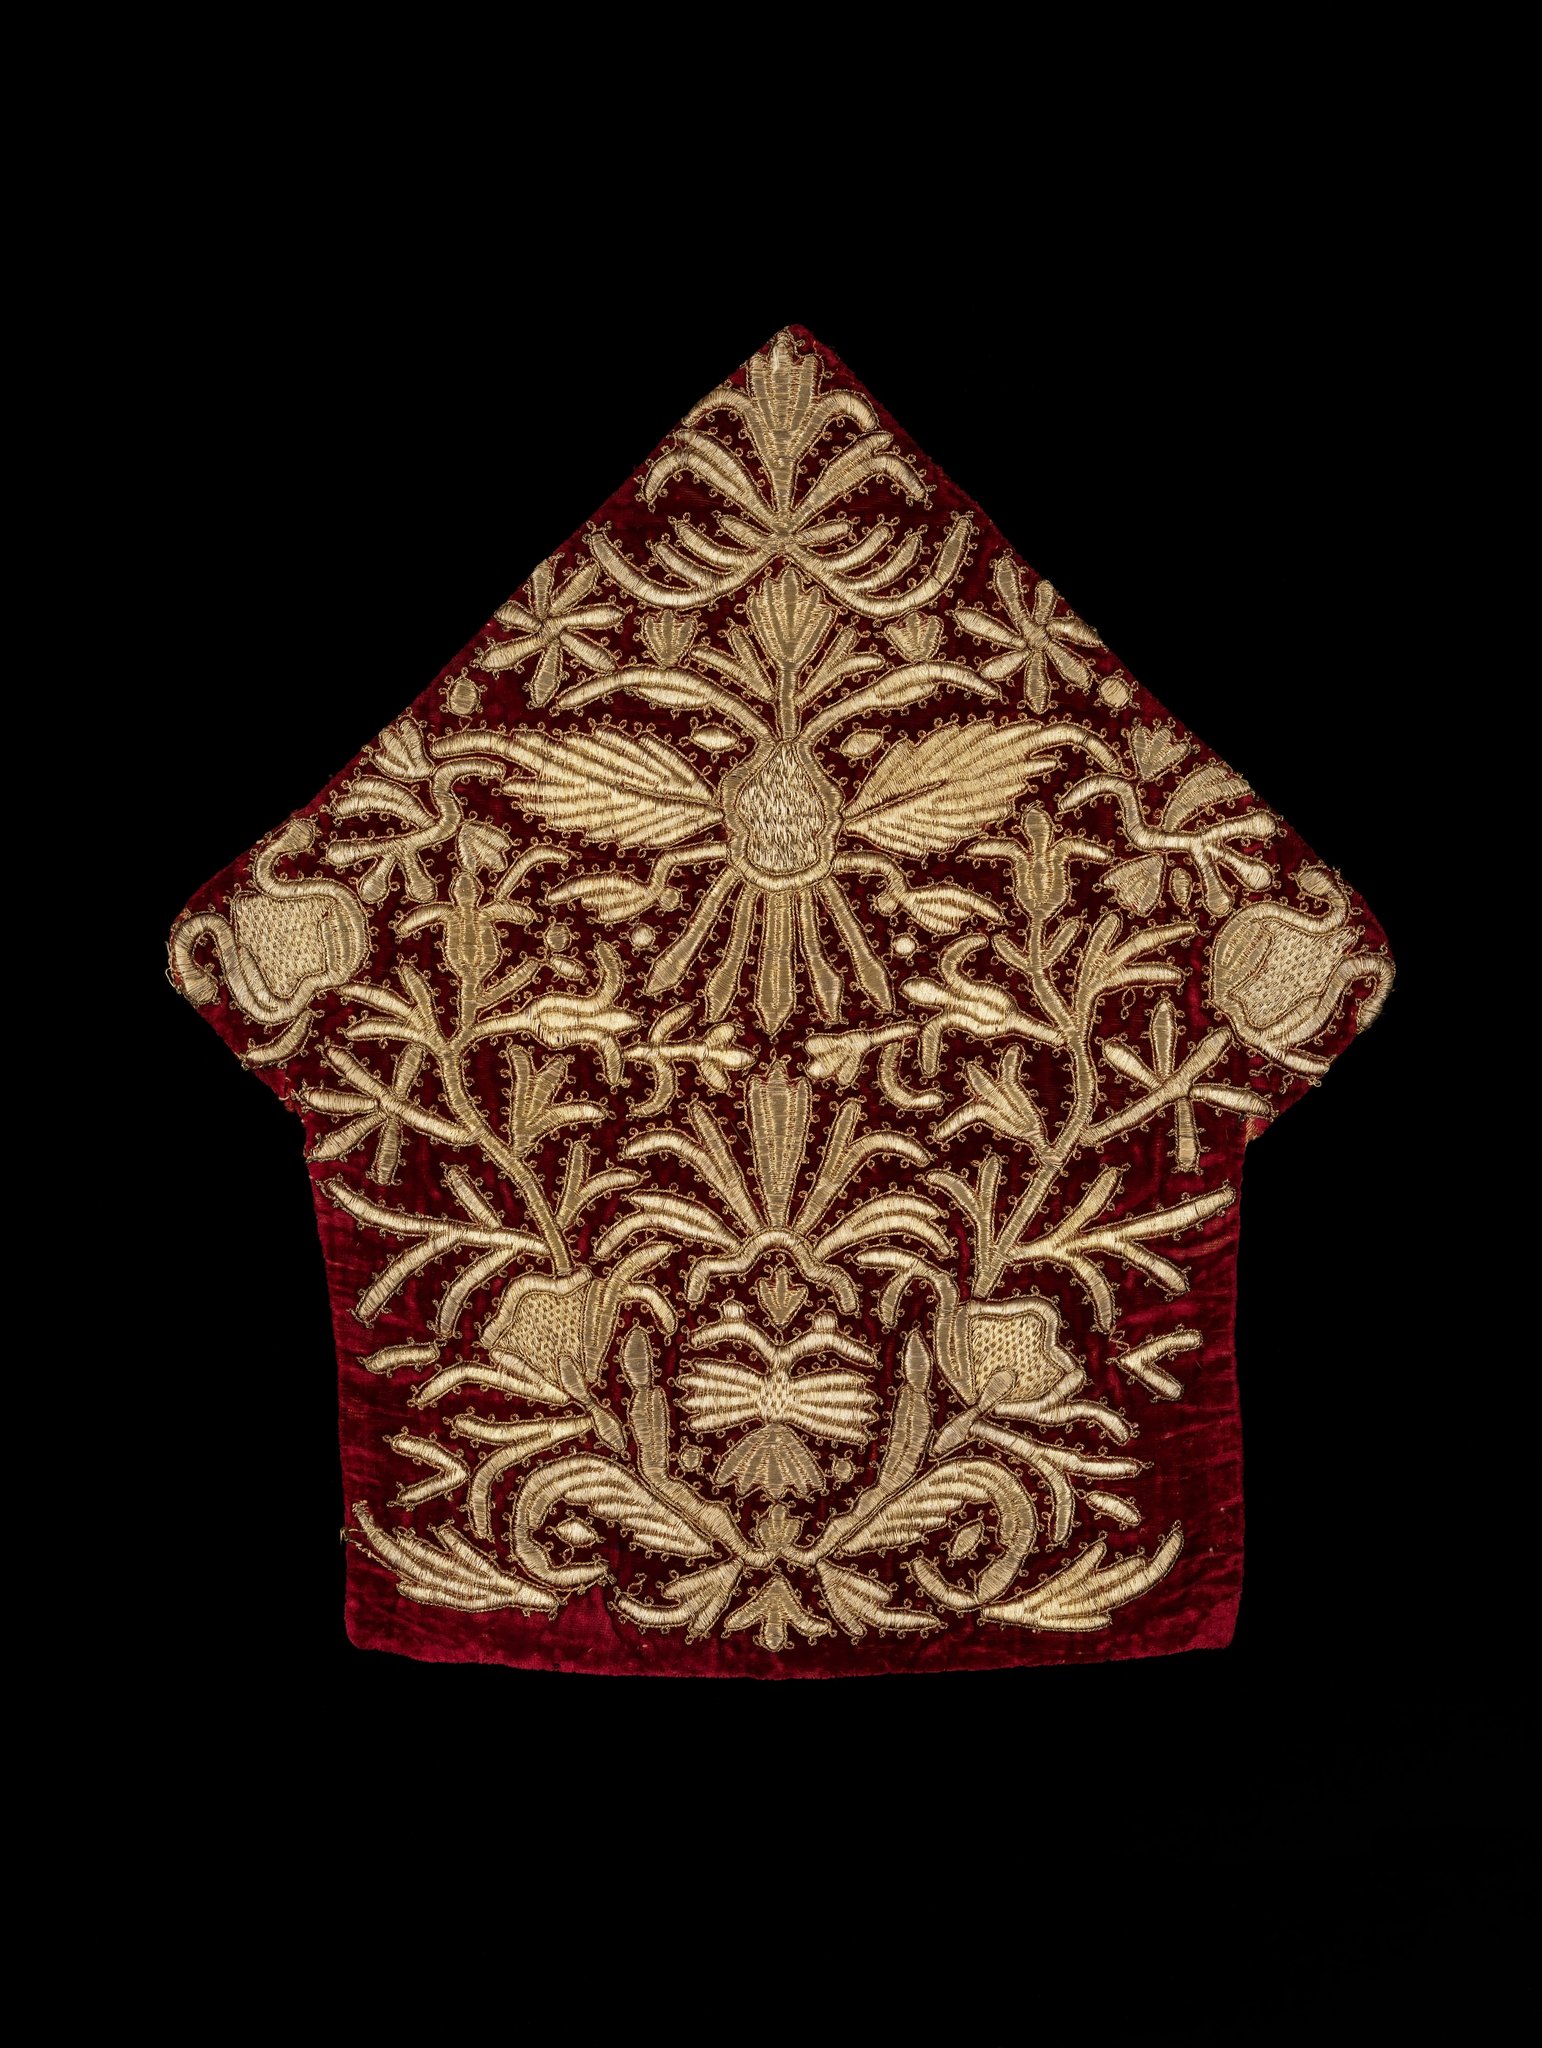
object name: headdress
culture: russian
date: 1830-1880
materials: linen, metal, silk